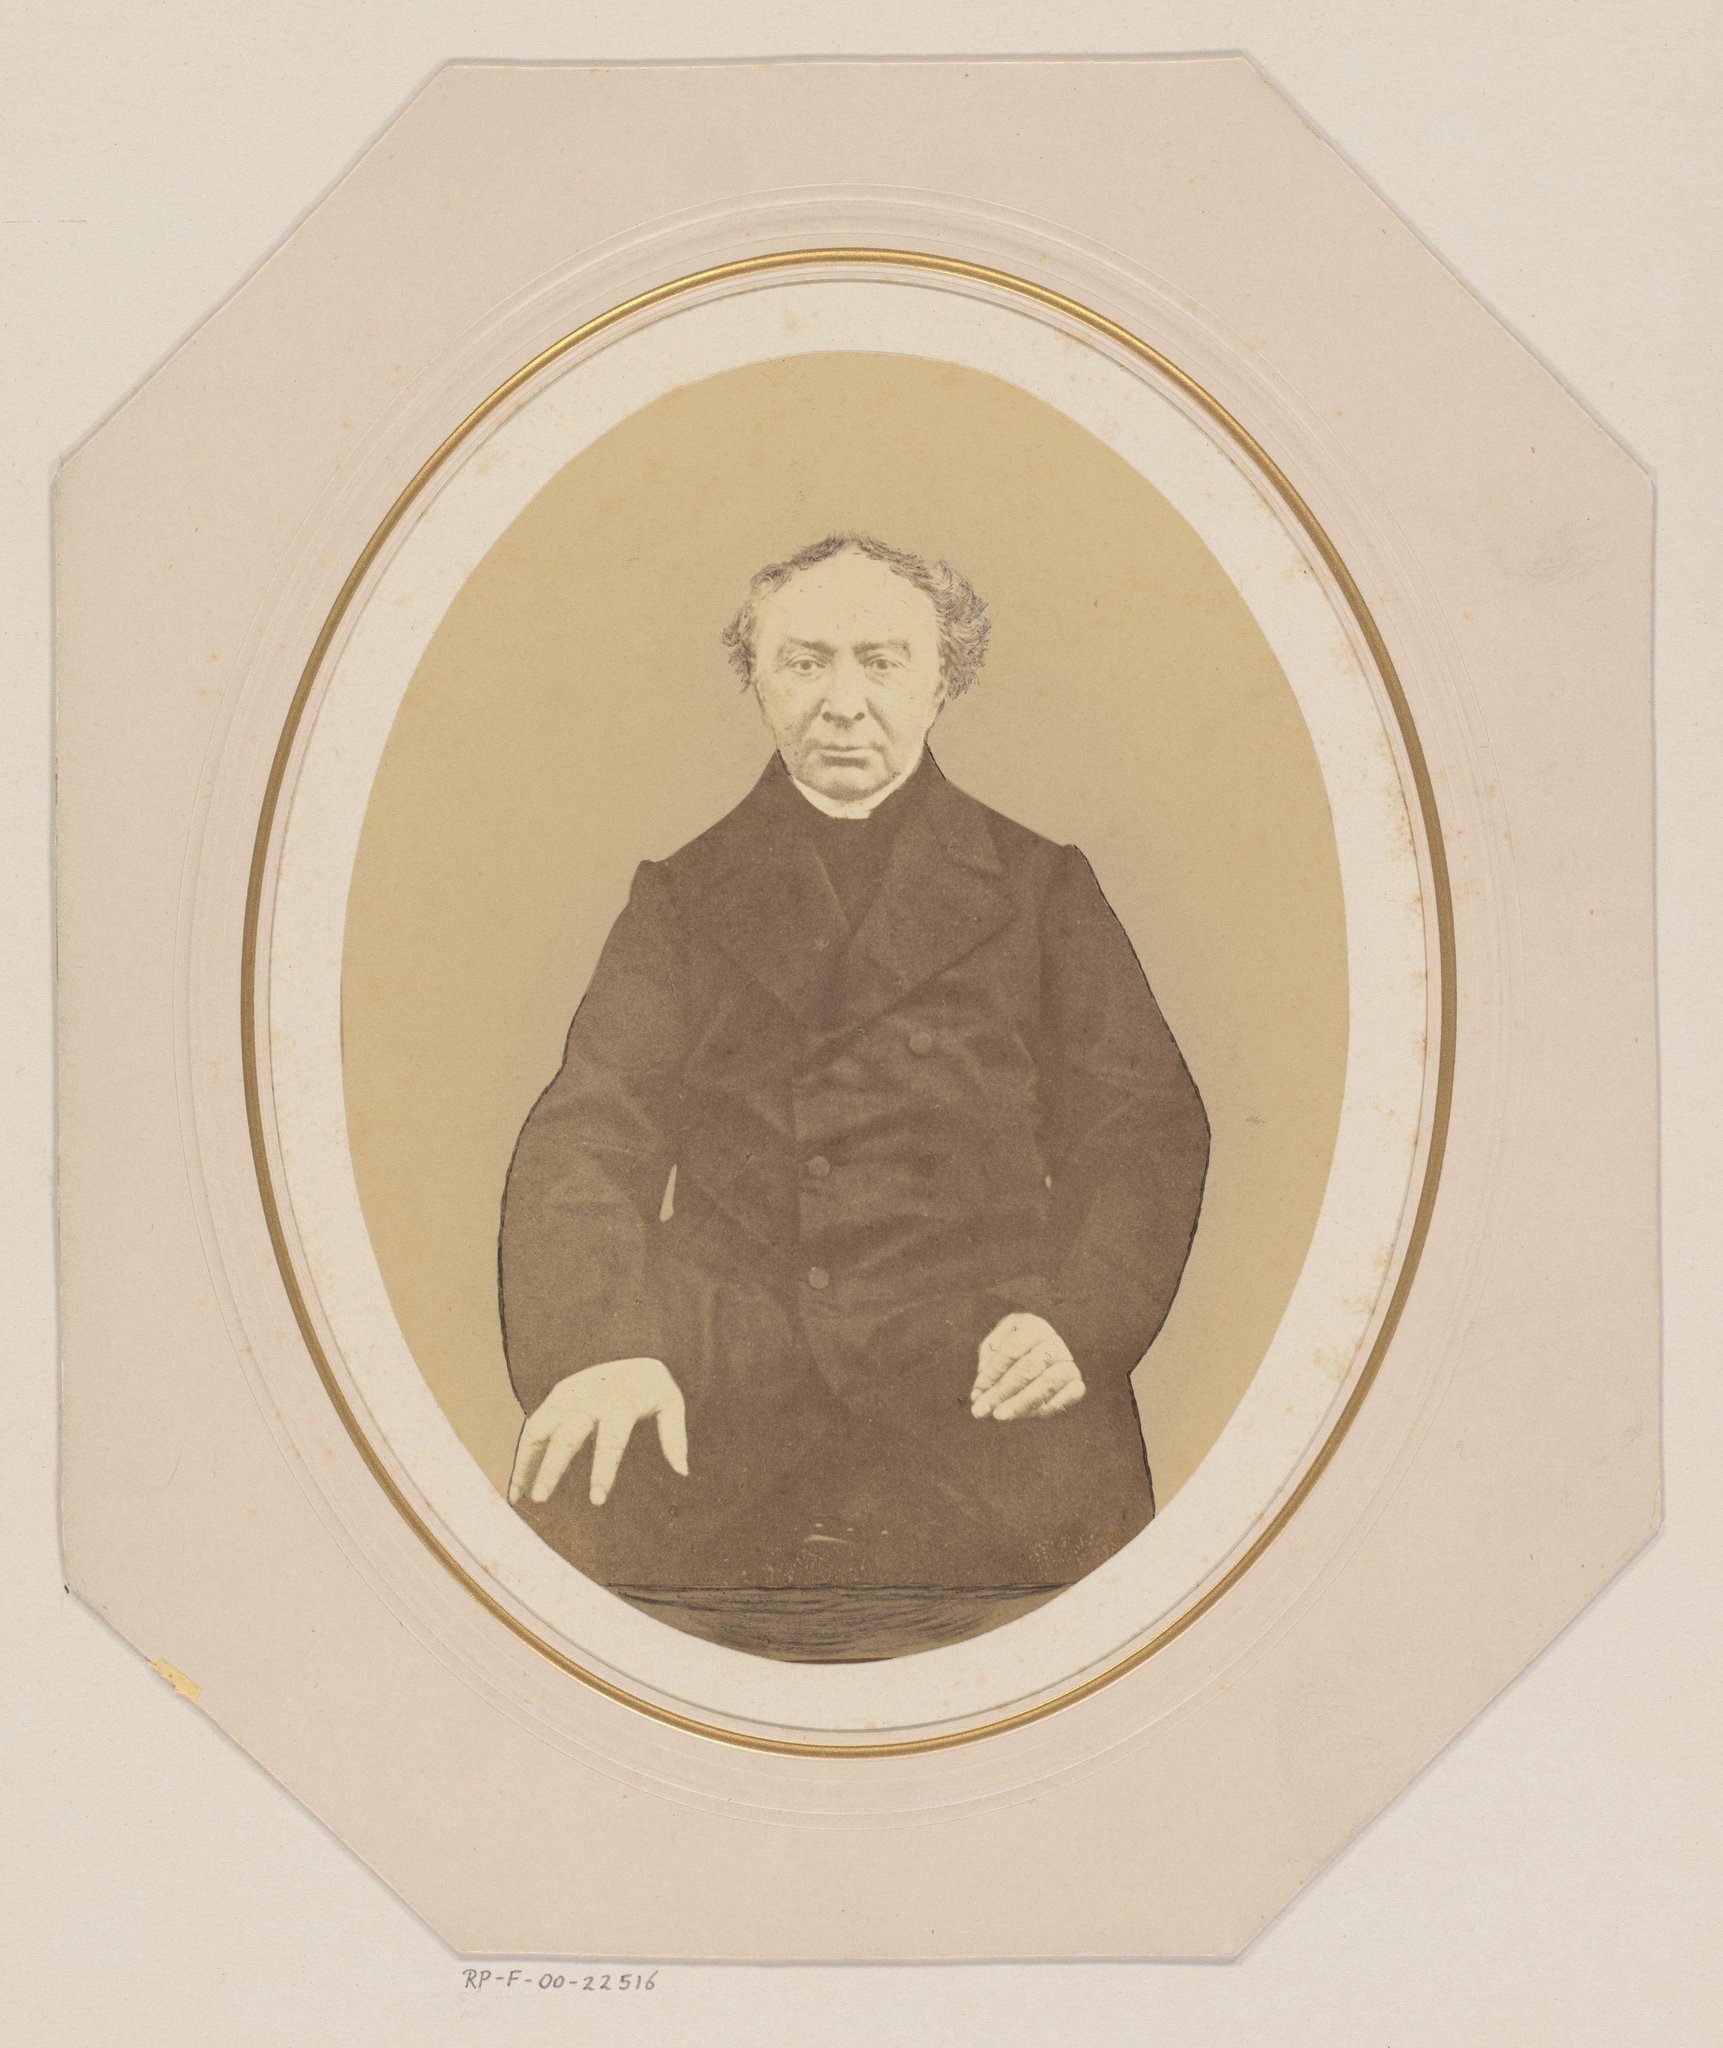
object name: photograph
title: Portret van Hendrik Frederik August Sasse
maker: Anonymous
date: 1855-1871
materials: cardboard, paper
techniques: albumen print, retouching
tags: historical persons, physician, doctor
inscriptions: inscription: ‘Dr. H.F.A. Sasse geb. 11 Febr 1800/ † te Rijp 11 Mei 1871/ G.d. 178.’